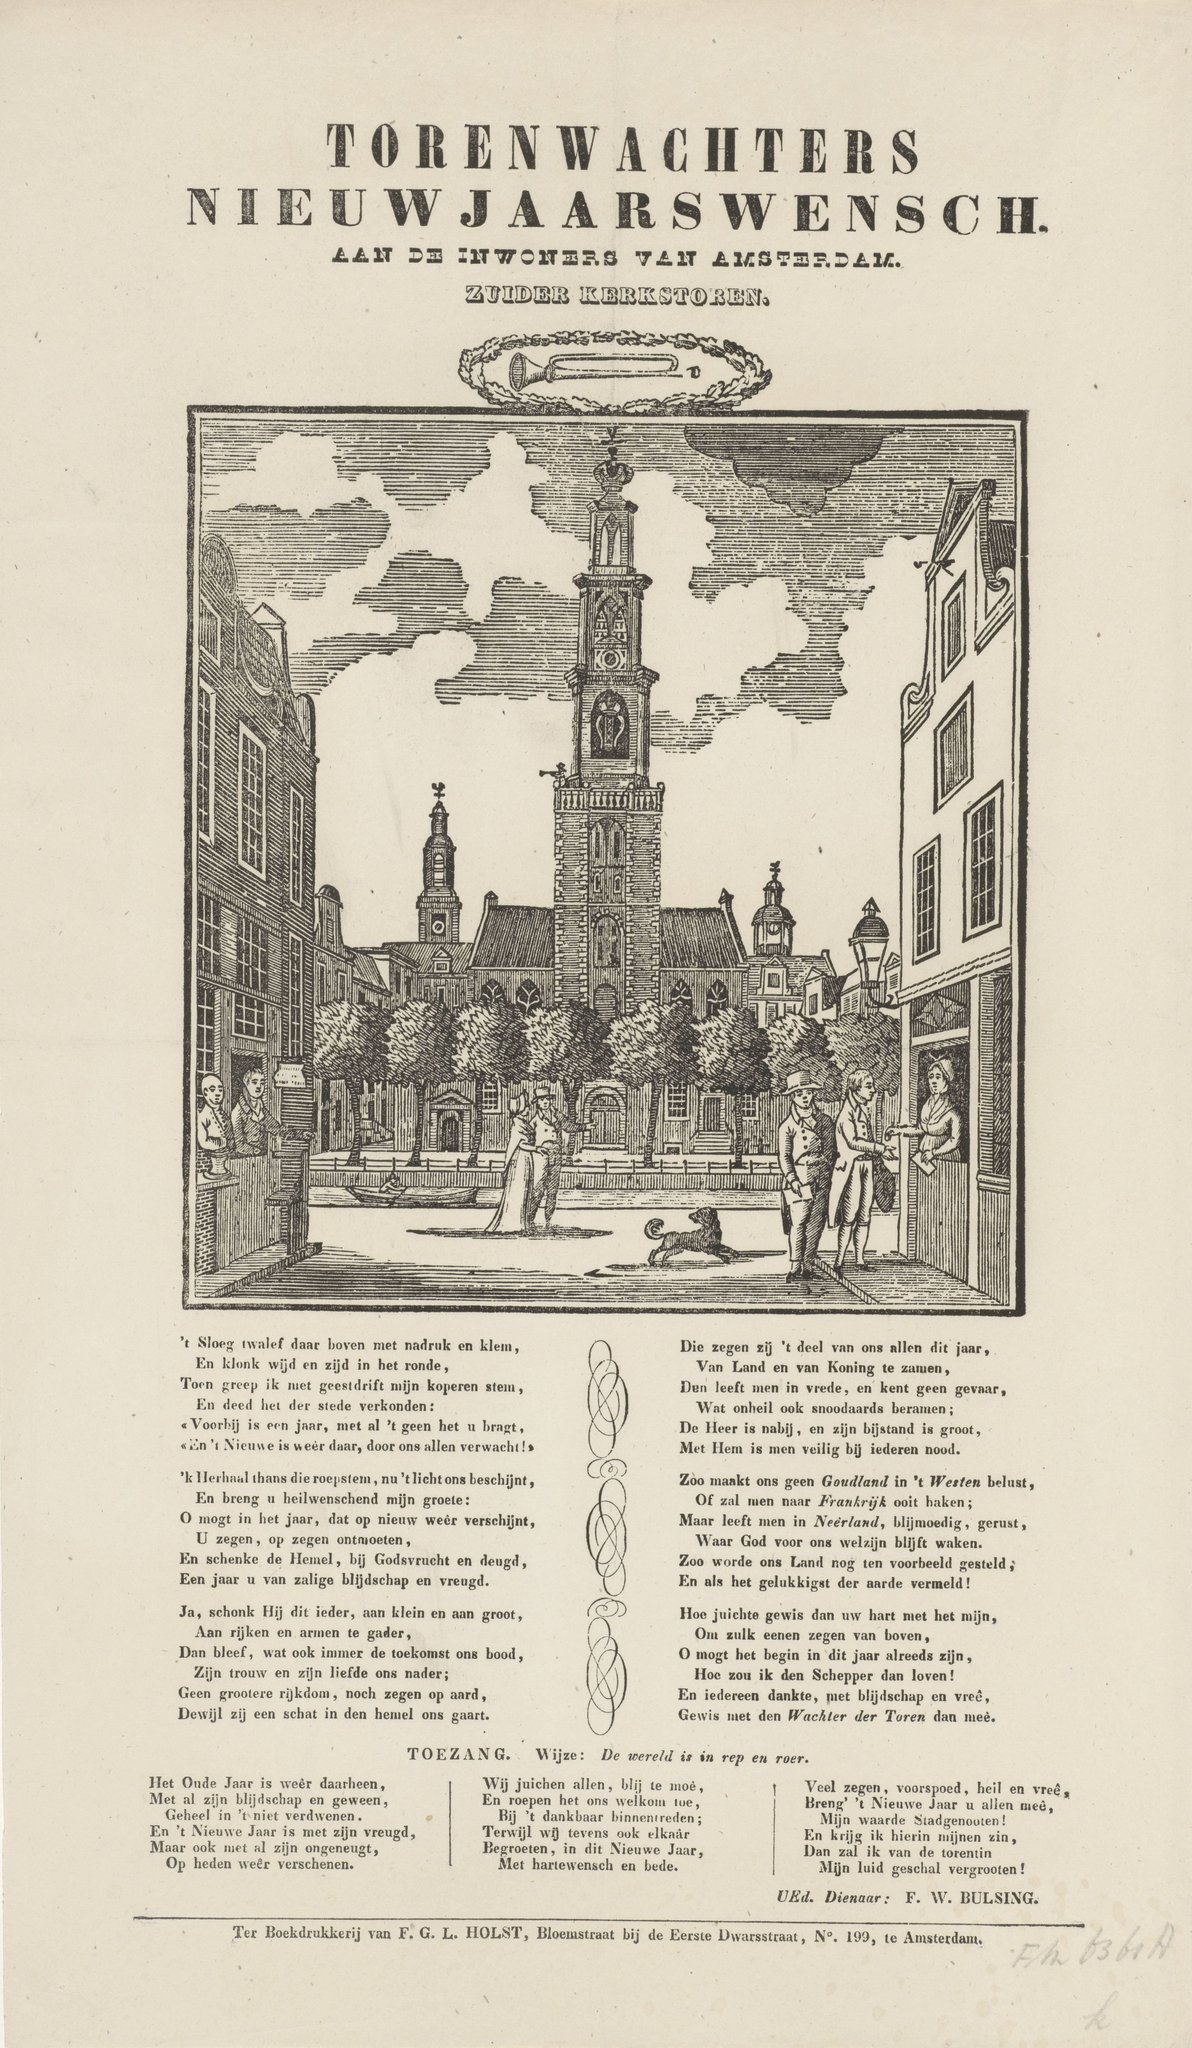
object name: print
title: Nieuwjaarswens van de torenwachters van de Zuiderkerk te Amsterdam, ca. 1840-1870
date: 1840-1870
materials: paper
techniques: letterpress printing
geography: amsterdam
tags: tower sentry, street, amsterdam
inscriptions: collector's mark: Lugt 2228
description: Nieuwjaarswens van de torenwachter van de Amsterdamse Zuiderkerk, ca. 1840-1870. Gezicht op de Westerkerk te Amsterdam, twee mannen halen aan de huizen geld op. Onderaan een gedicht in twee kolommen en een lied in drie verzen. Van de torenwachter: F.W. Bulsing.